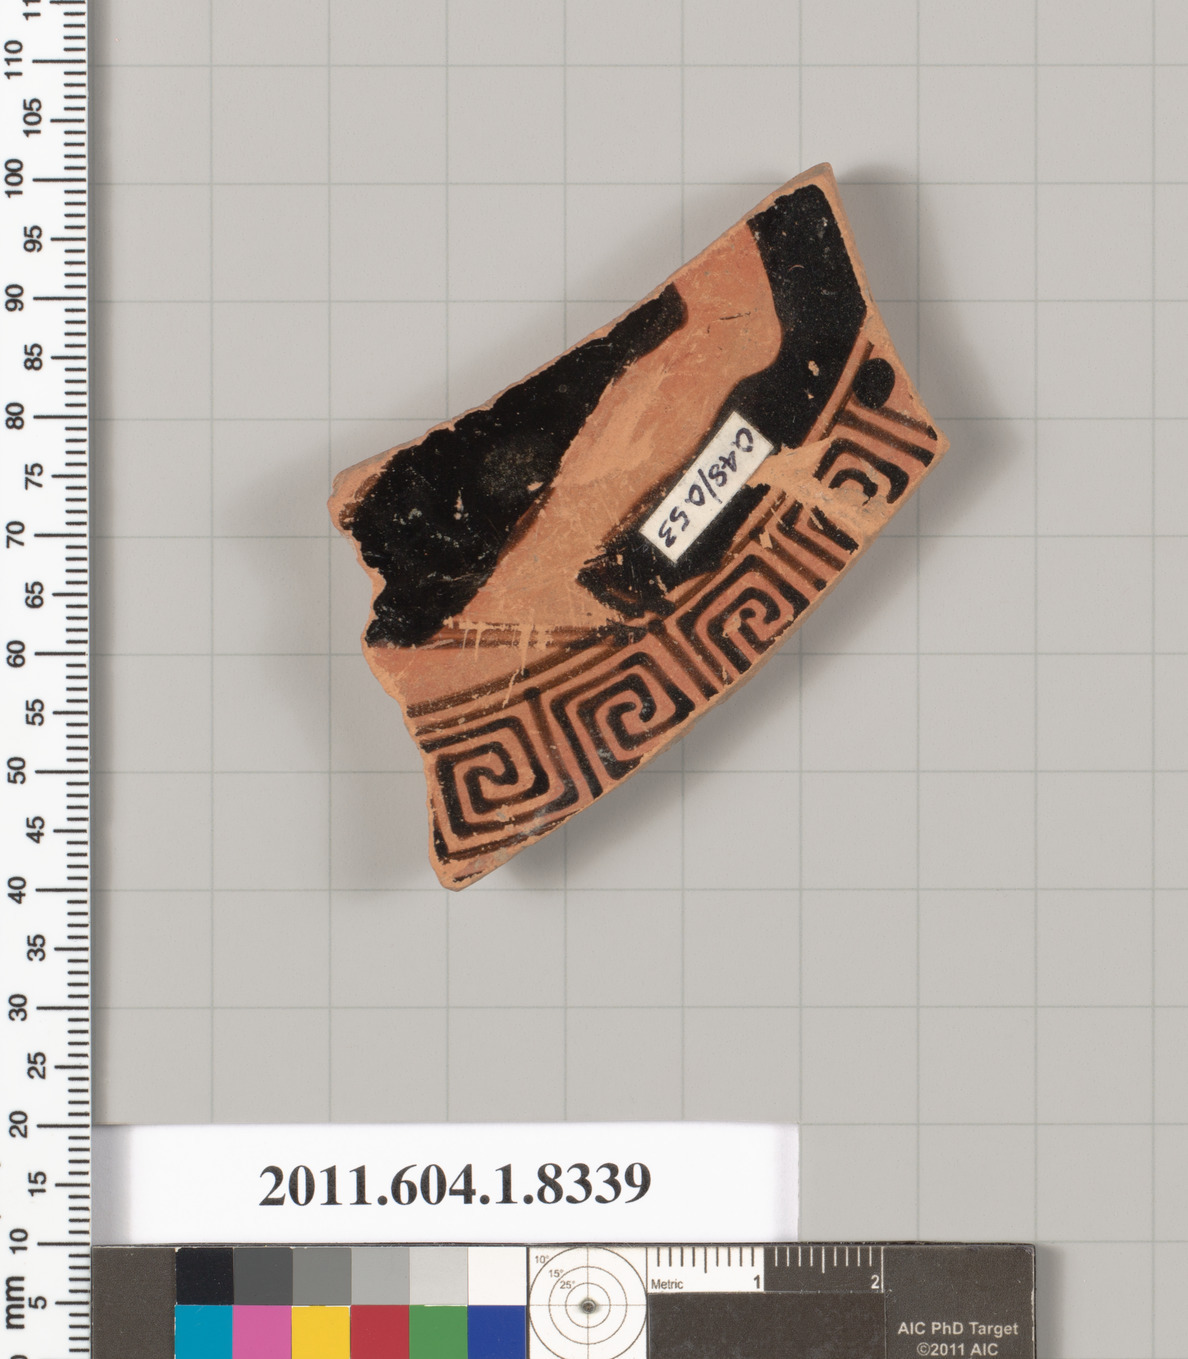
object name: kylix fragment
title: Terracotta fragment of a kylix (drinking cup)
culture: greek, attic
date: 400-351 BCE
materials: terracotta